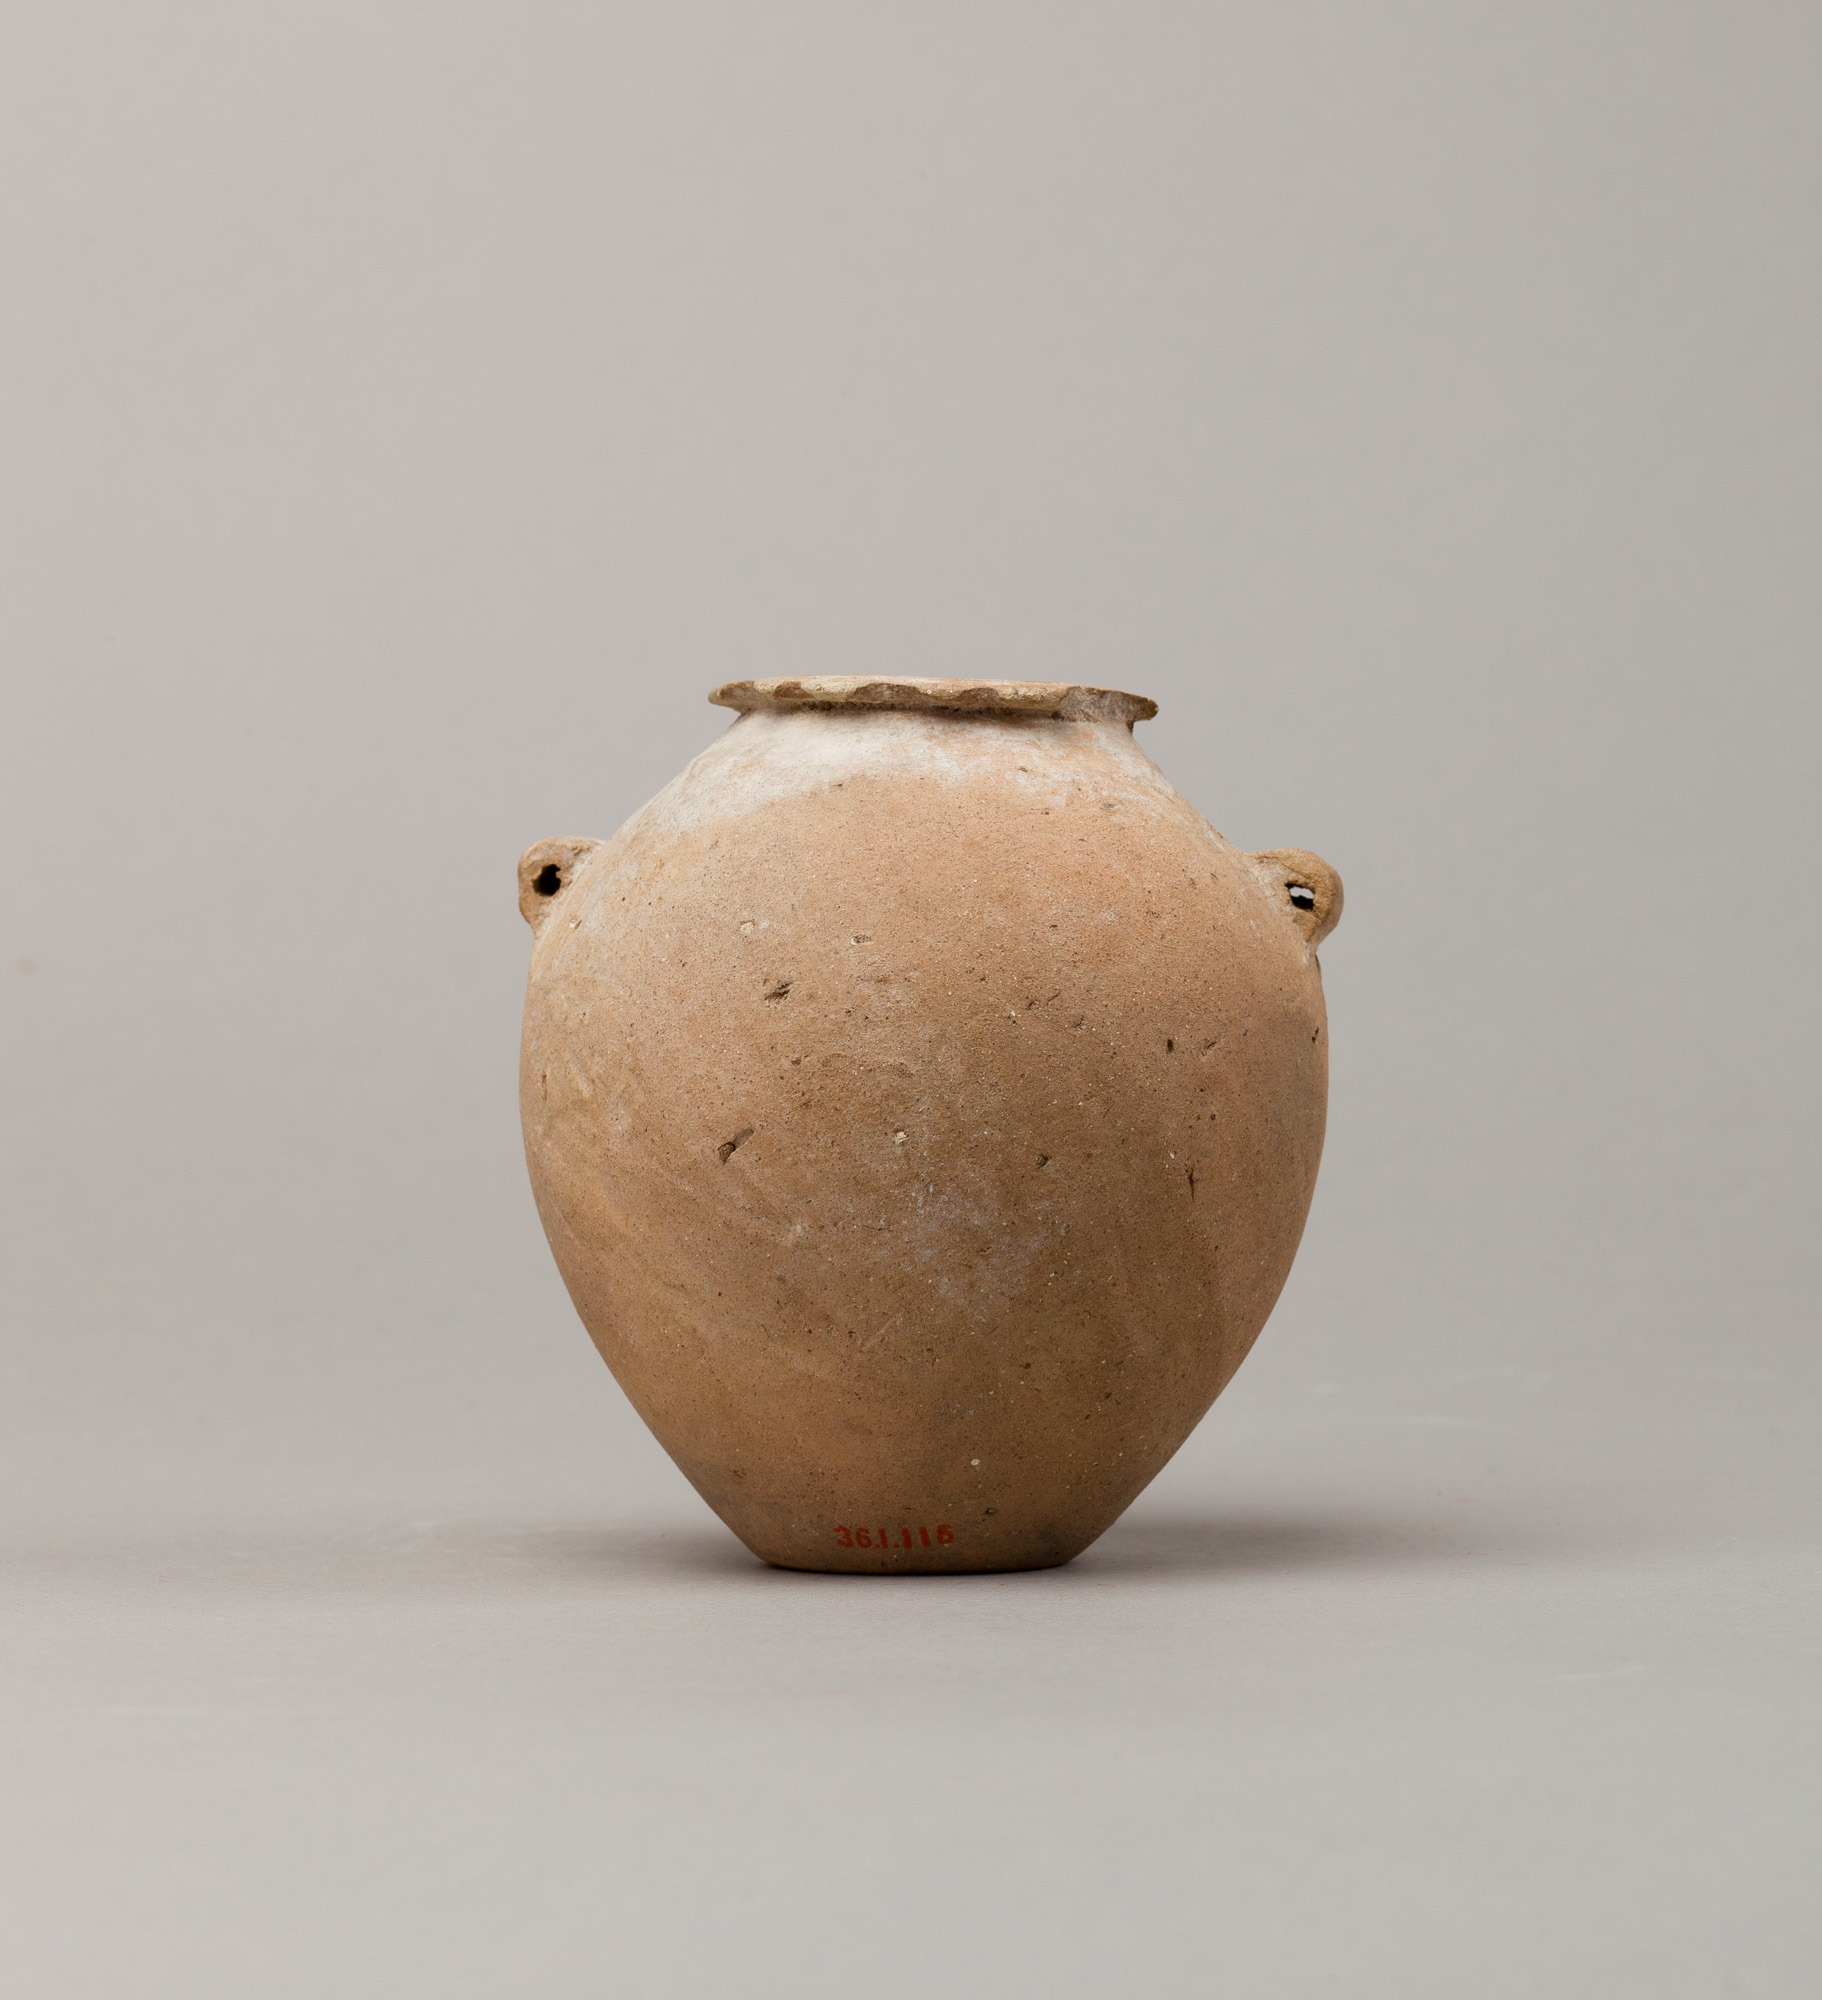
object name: jar, gooleh marl ware, lug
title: Marl ware jar with lug handles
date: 3850-2960 BCE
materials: pottery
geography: egypt